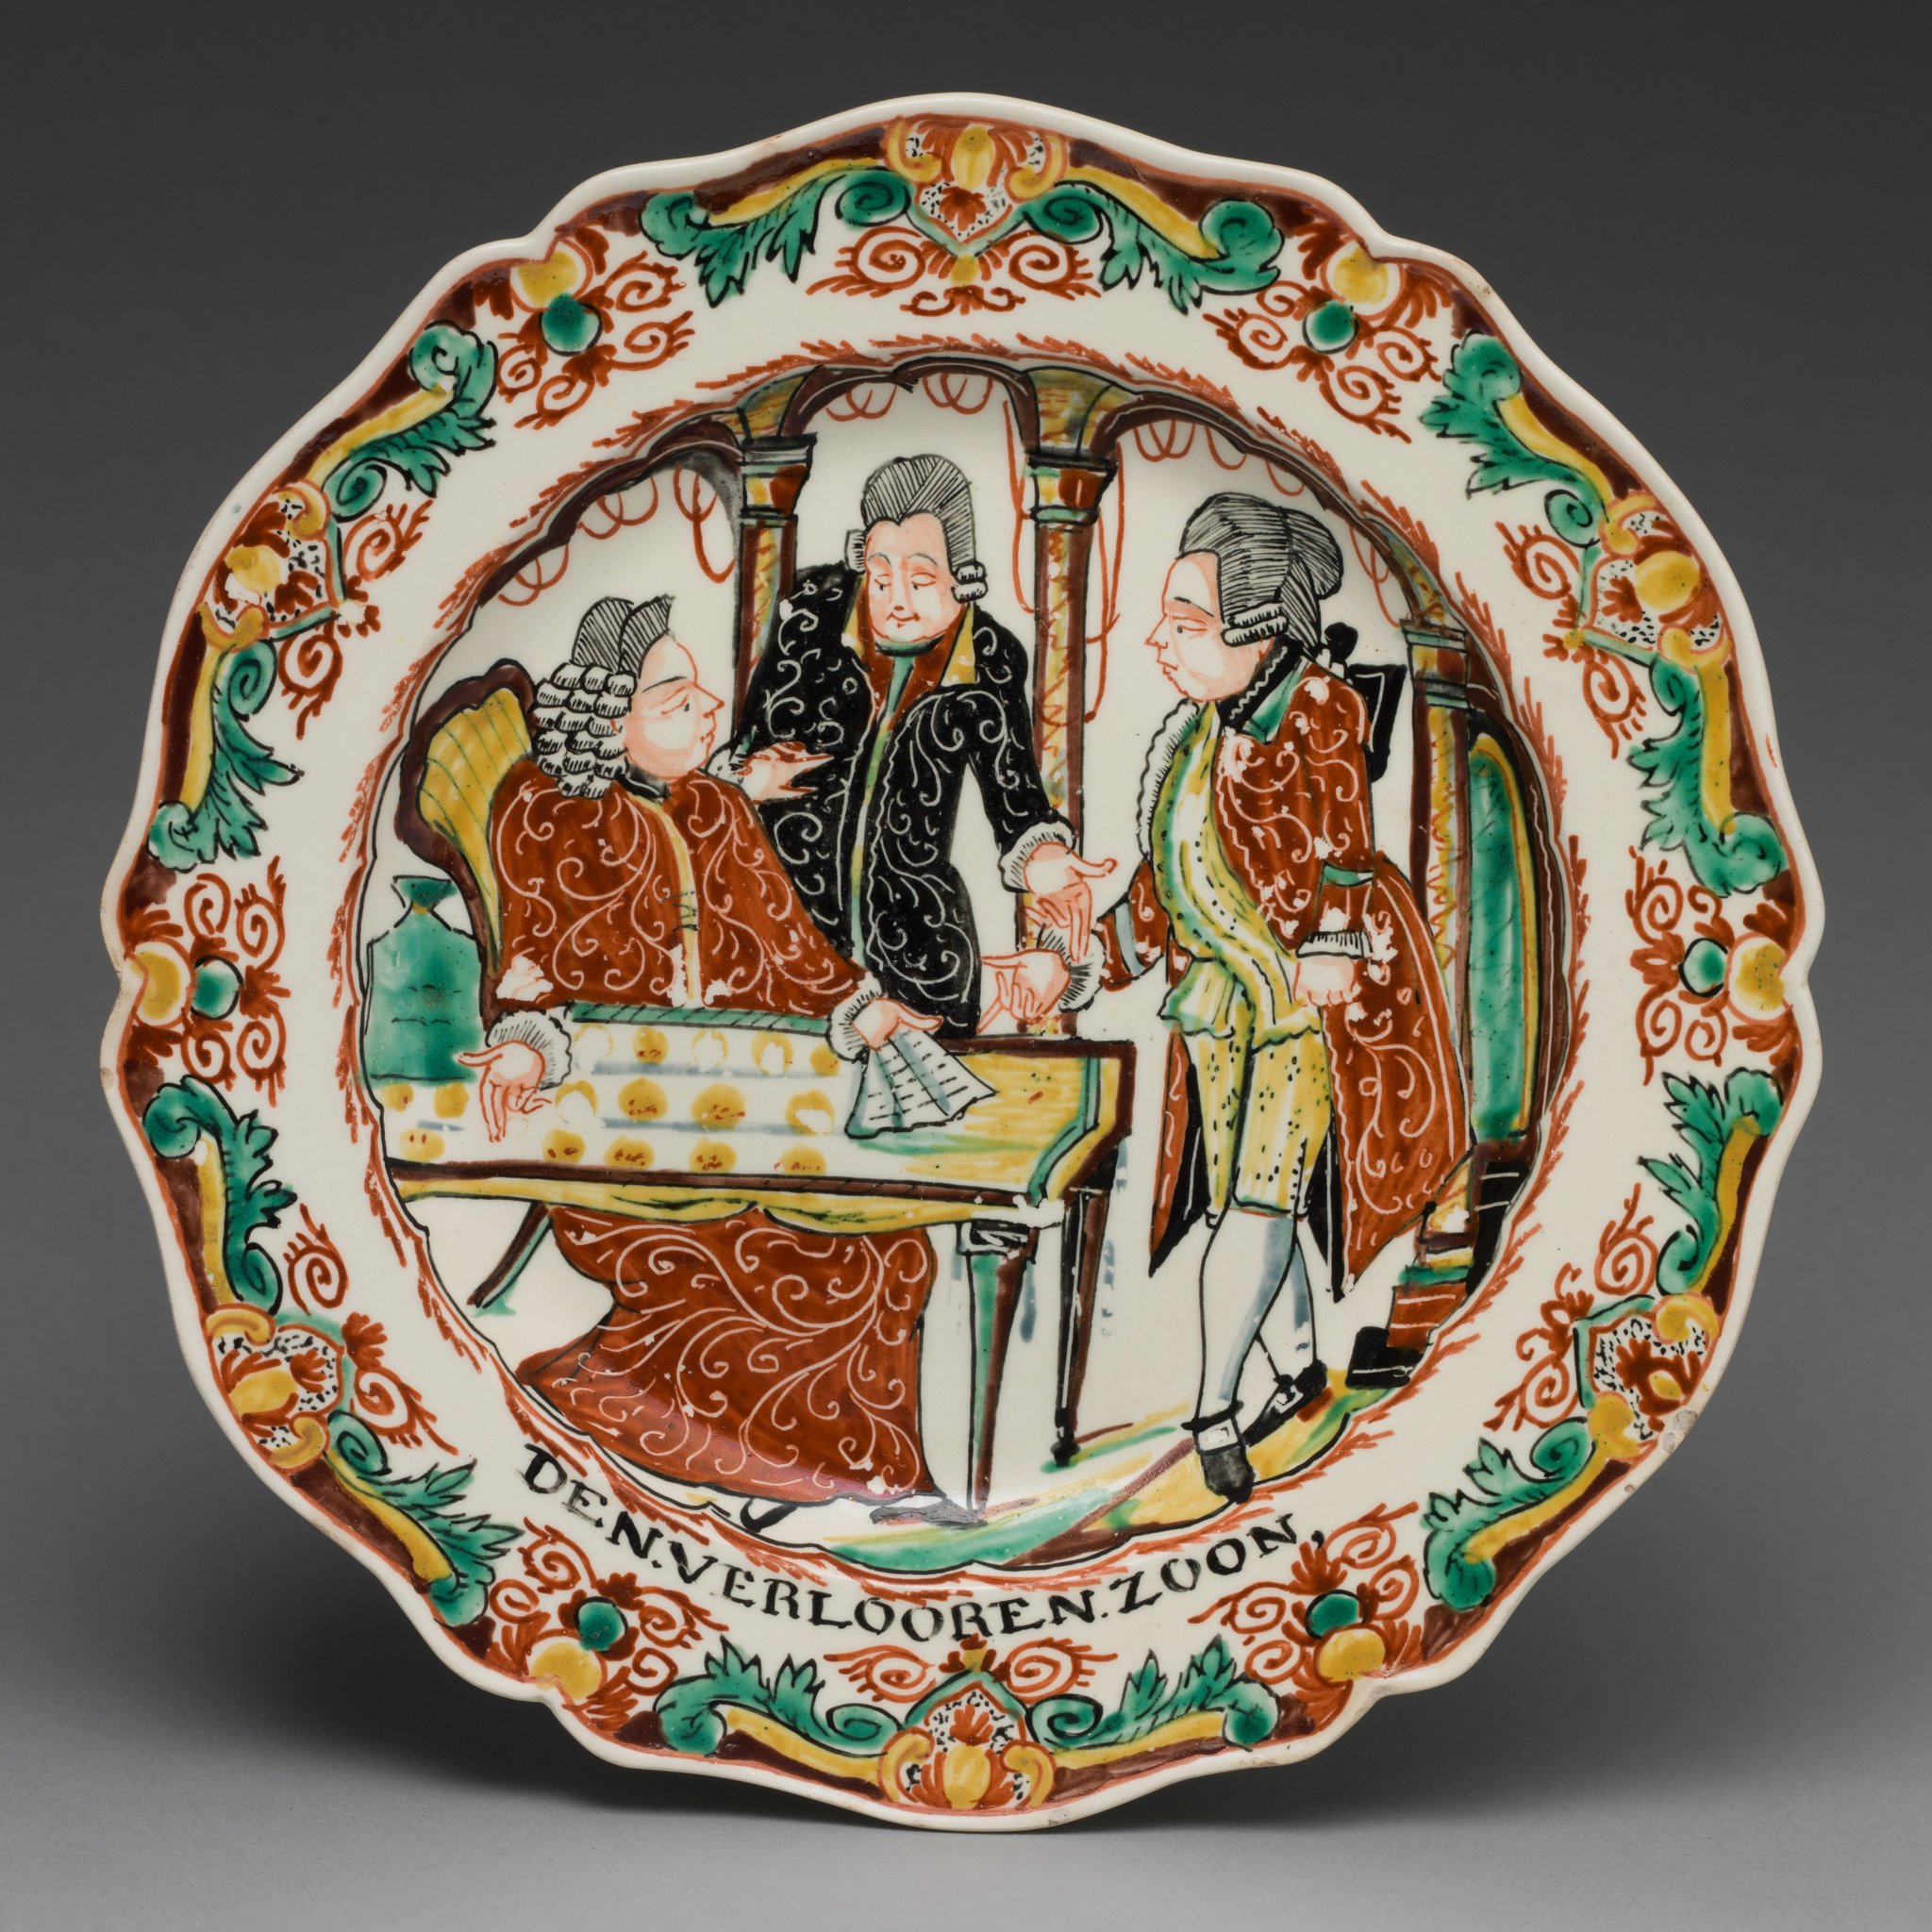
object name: plate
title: Plate (part of a set of six)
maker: john turner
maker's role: artist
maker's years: 1762-1786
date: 1790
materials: earthenware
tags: men